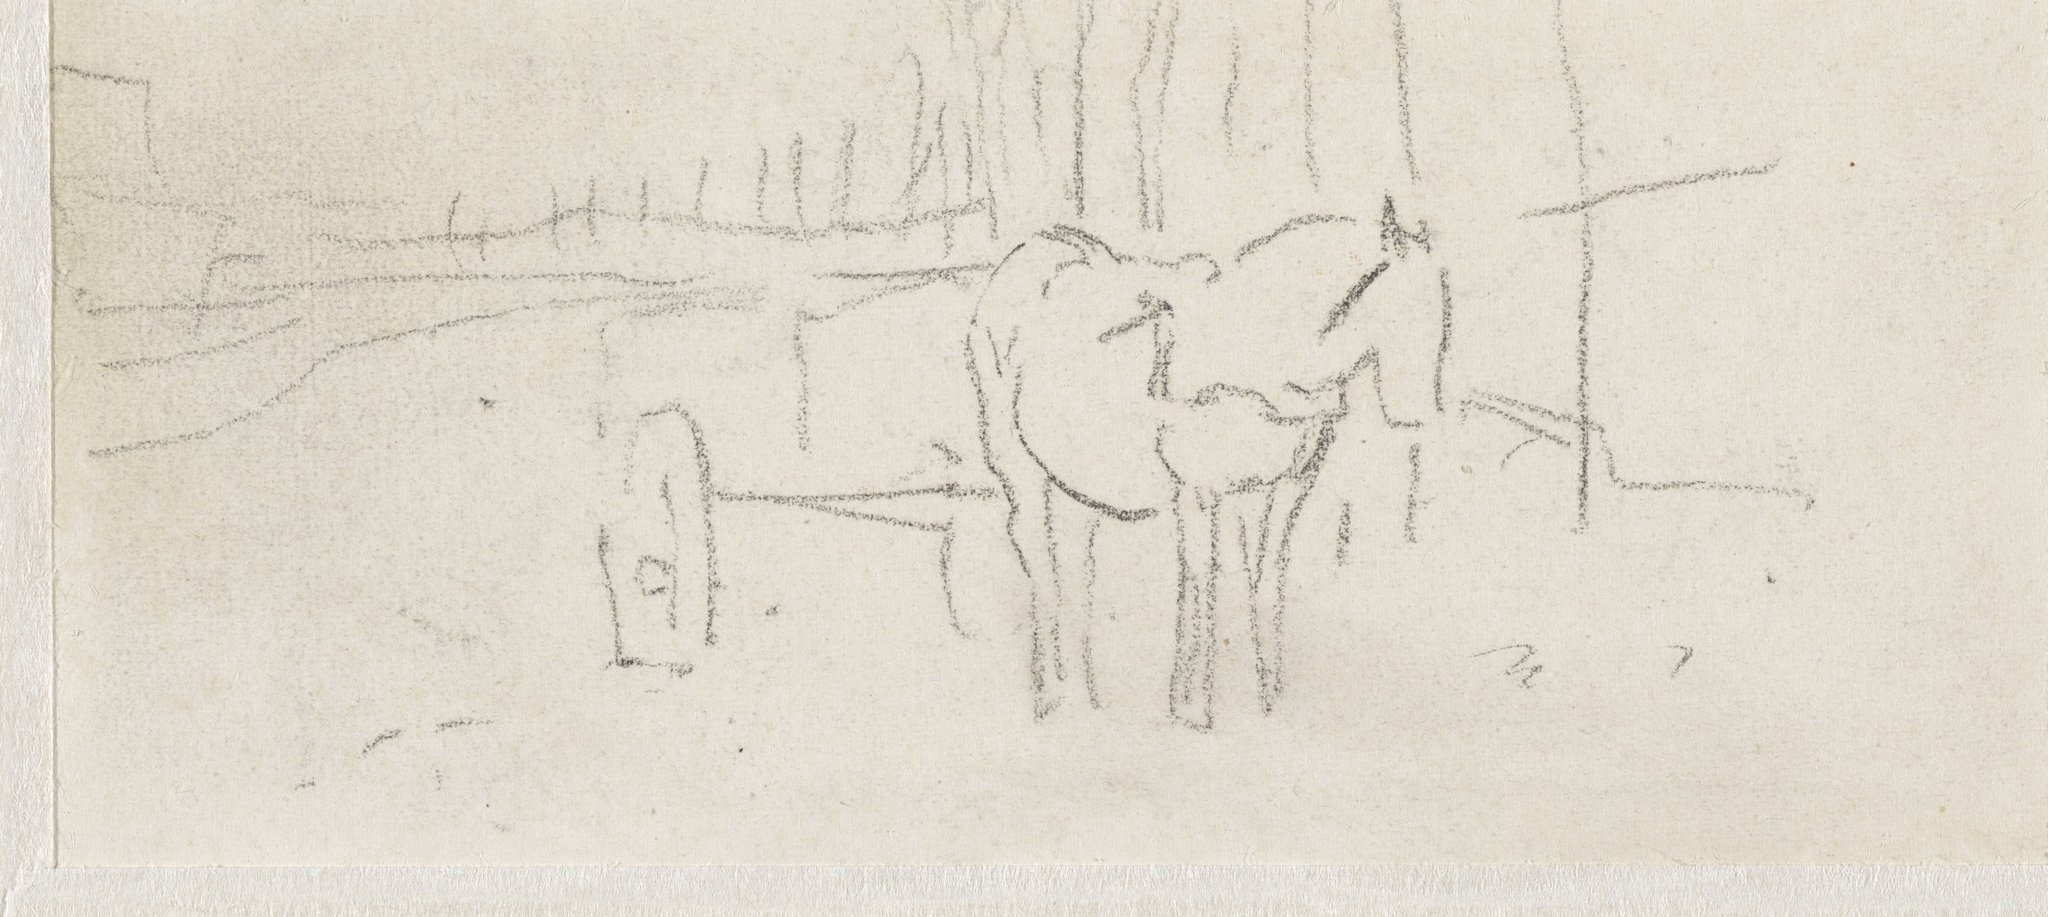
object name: drawing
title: Paard en wagen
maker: anton mauve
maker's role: draughtsman, painter, print maker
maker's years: 1838-1888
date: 1848-1888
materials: chalk, paper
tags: (farm) wagon, freight wagon, cart